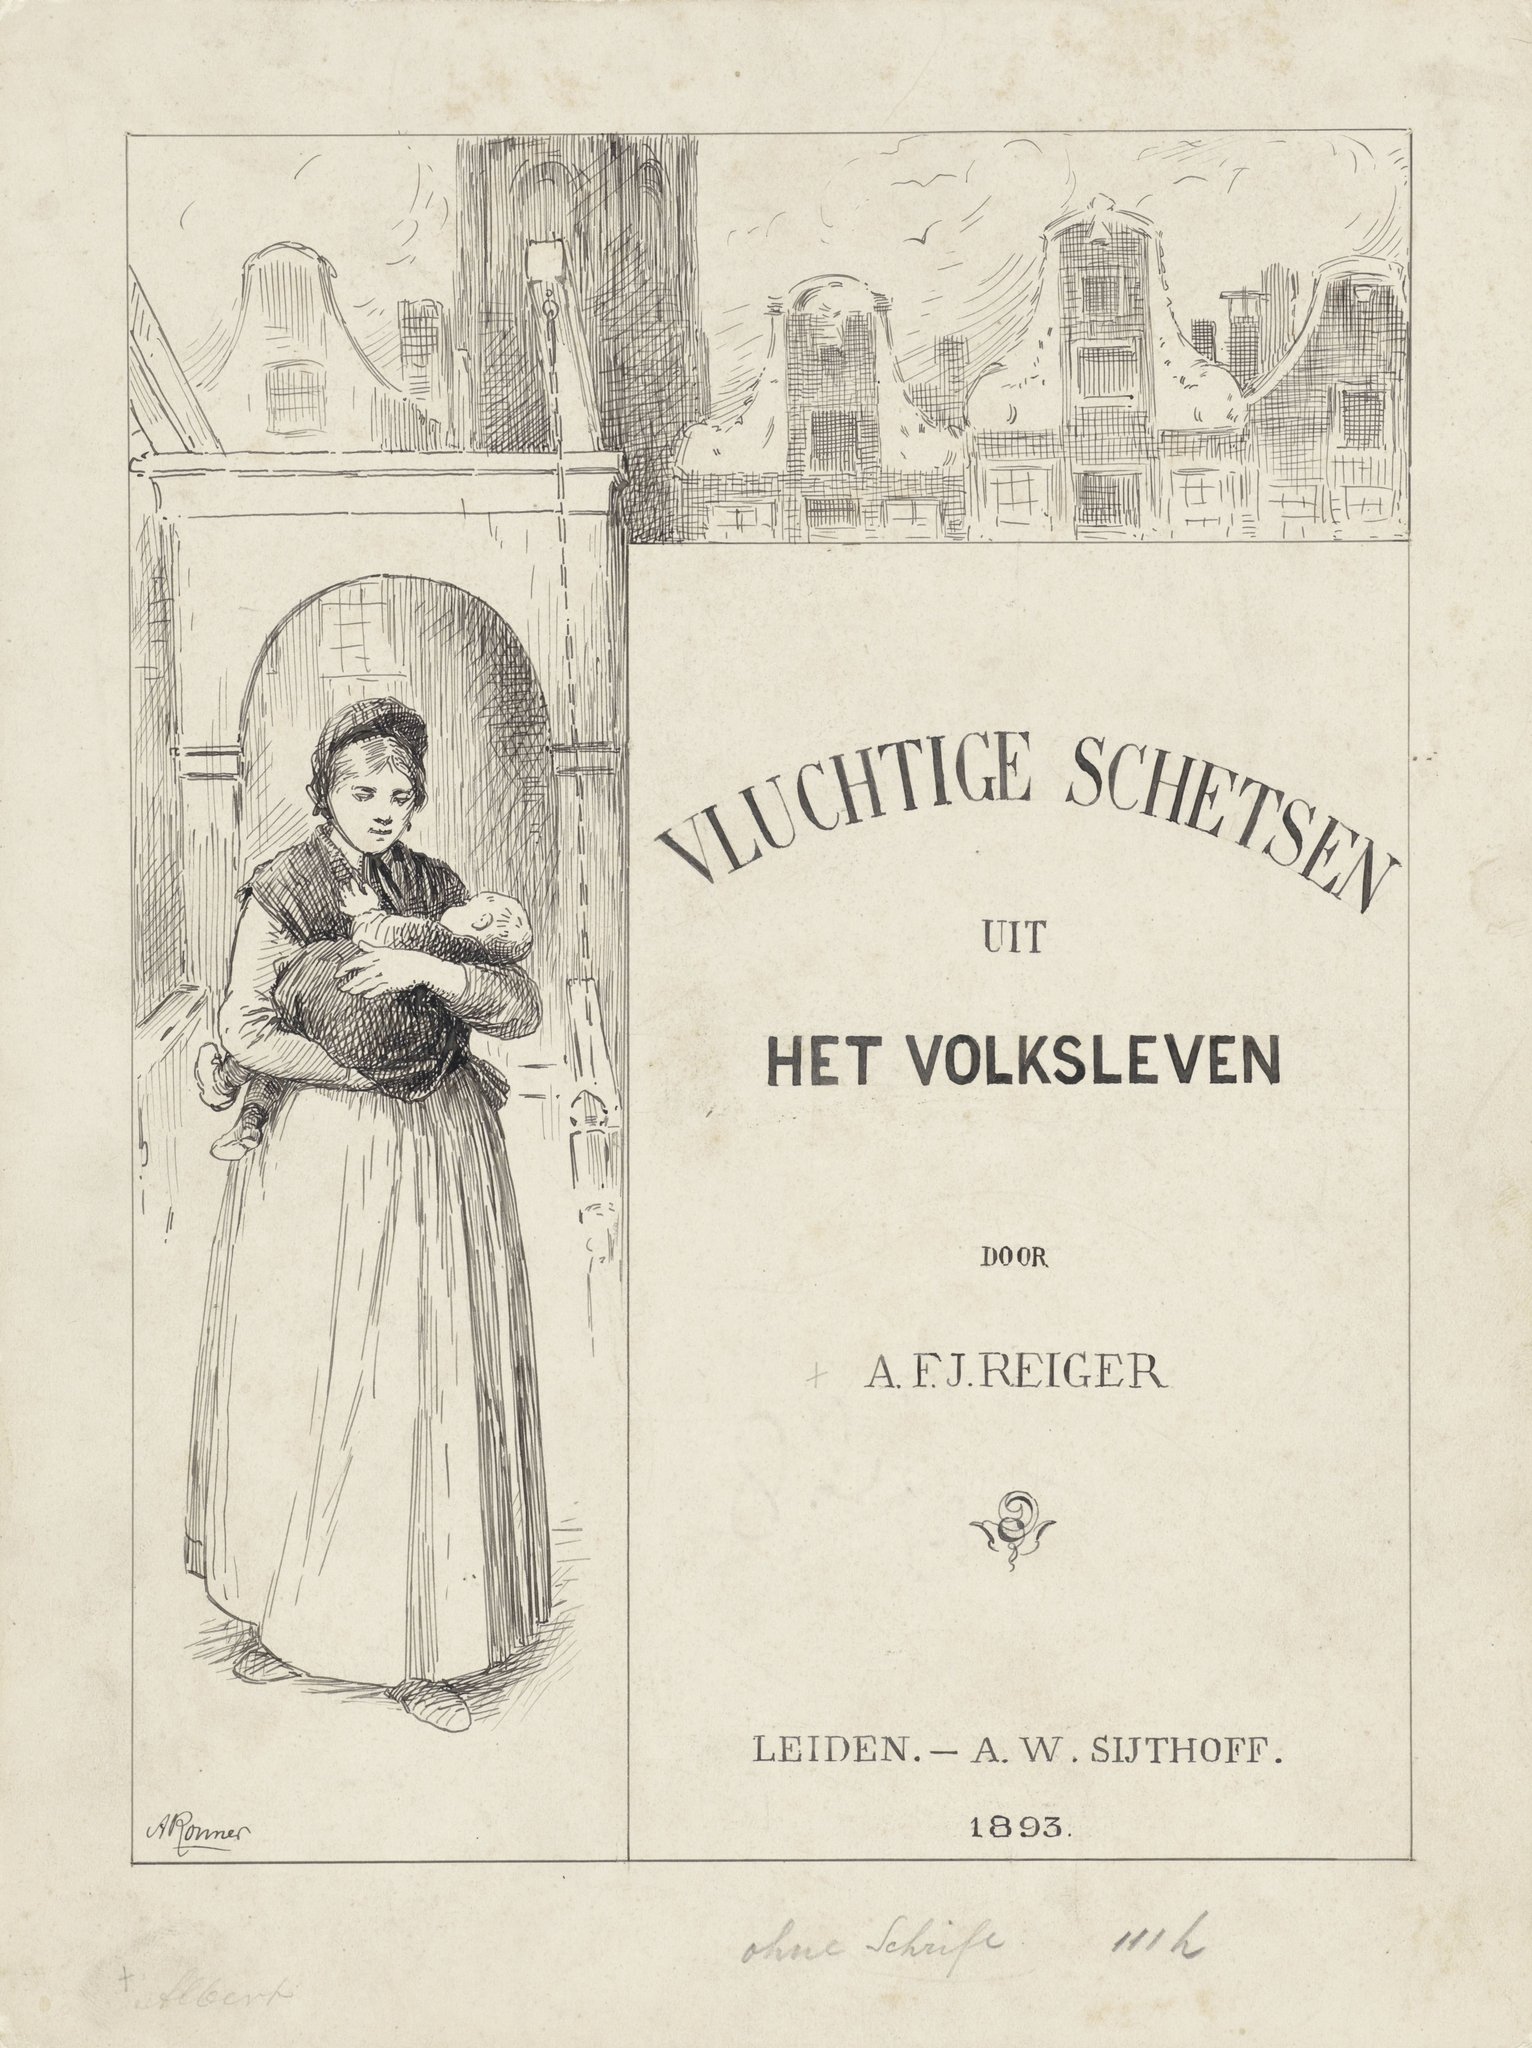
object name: design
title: Titelblad voor Vluchtige Schetsen uit het Volksleven door A.F.J. Reiger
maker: alfred ronner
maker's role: draughtsman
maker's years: 1852-1901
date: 1893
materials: ink, paper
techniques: pen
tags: (reiger, a.f.j., vluchtige schetsen uit het volksleven) specific works of literature (with author, title), mother and baby or young child